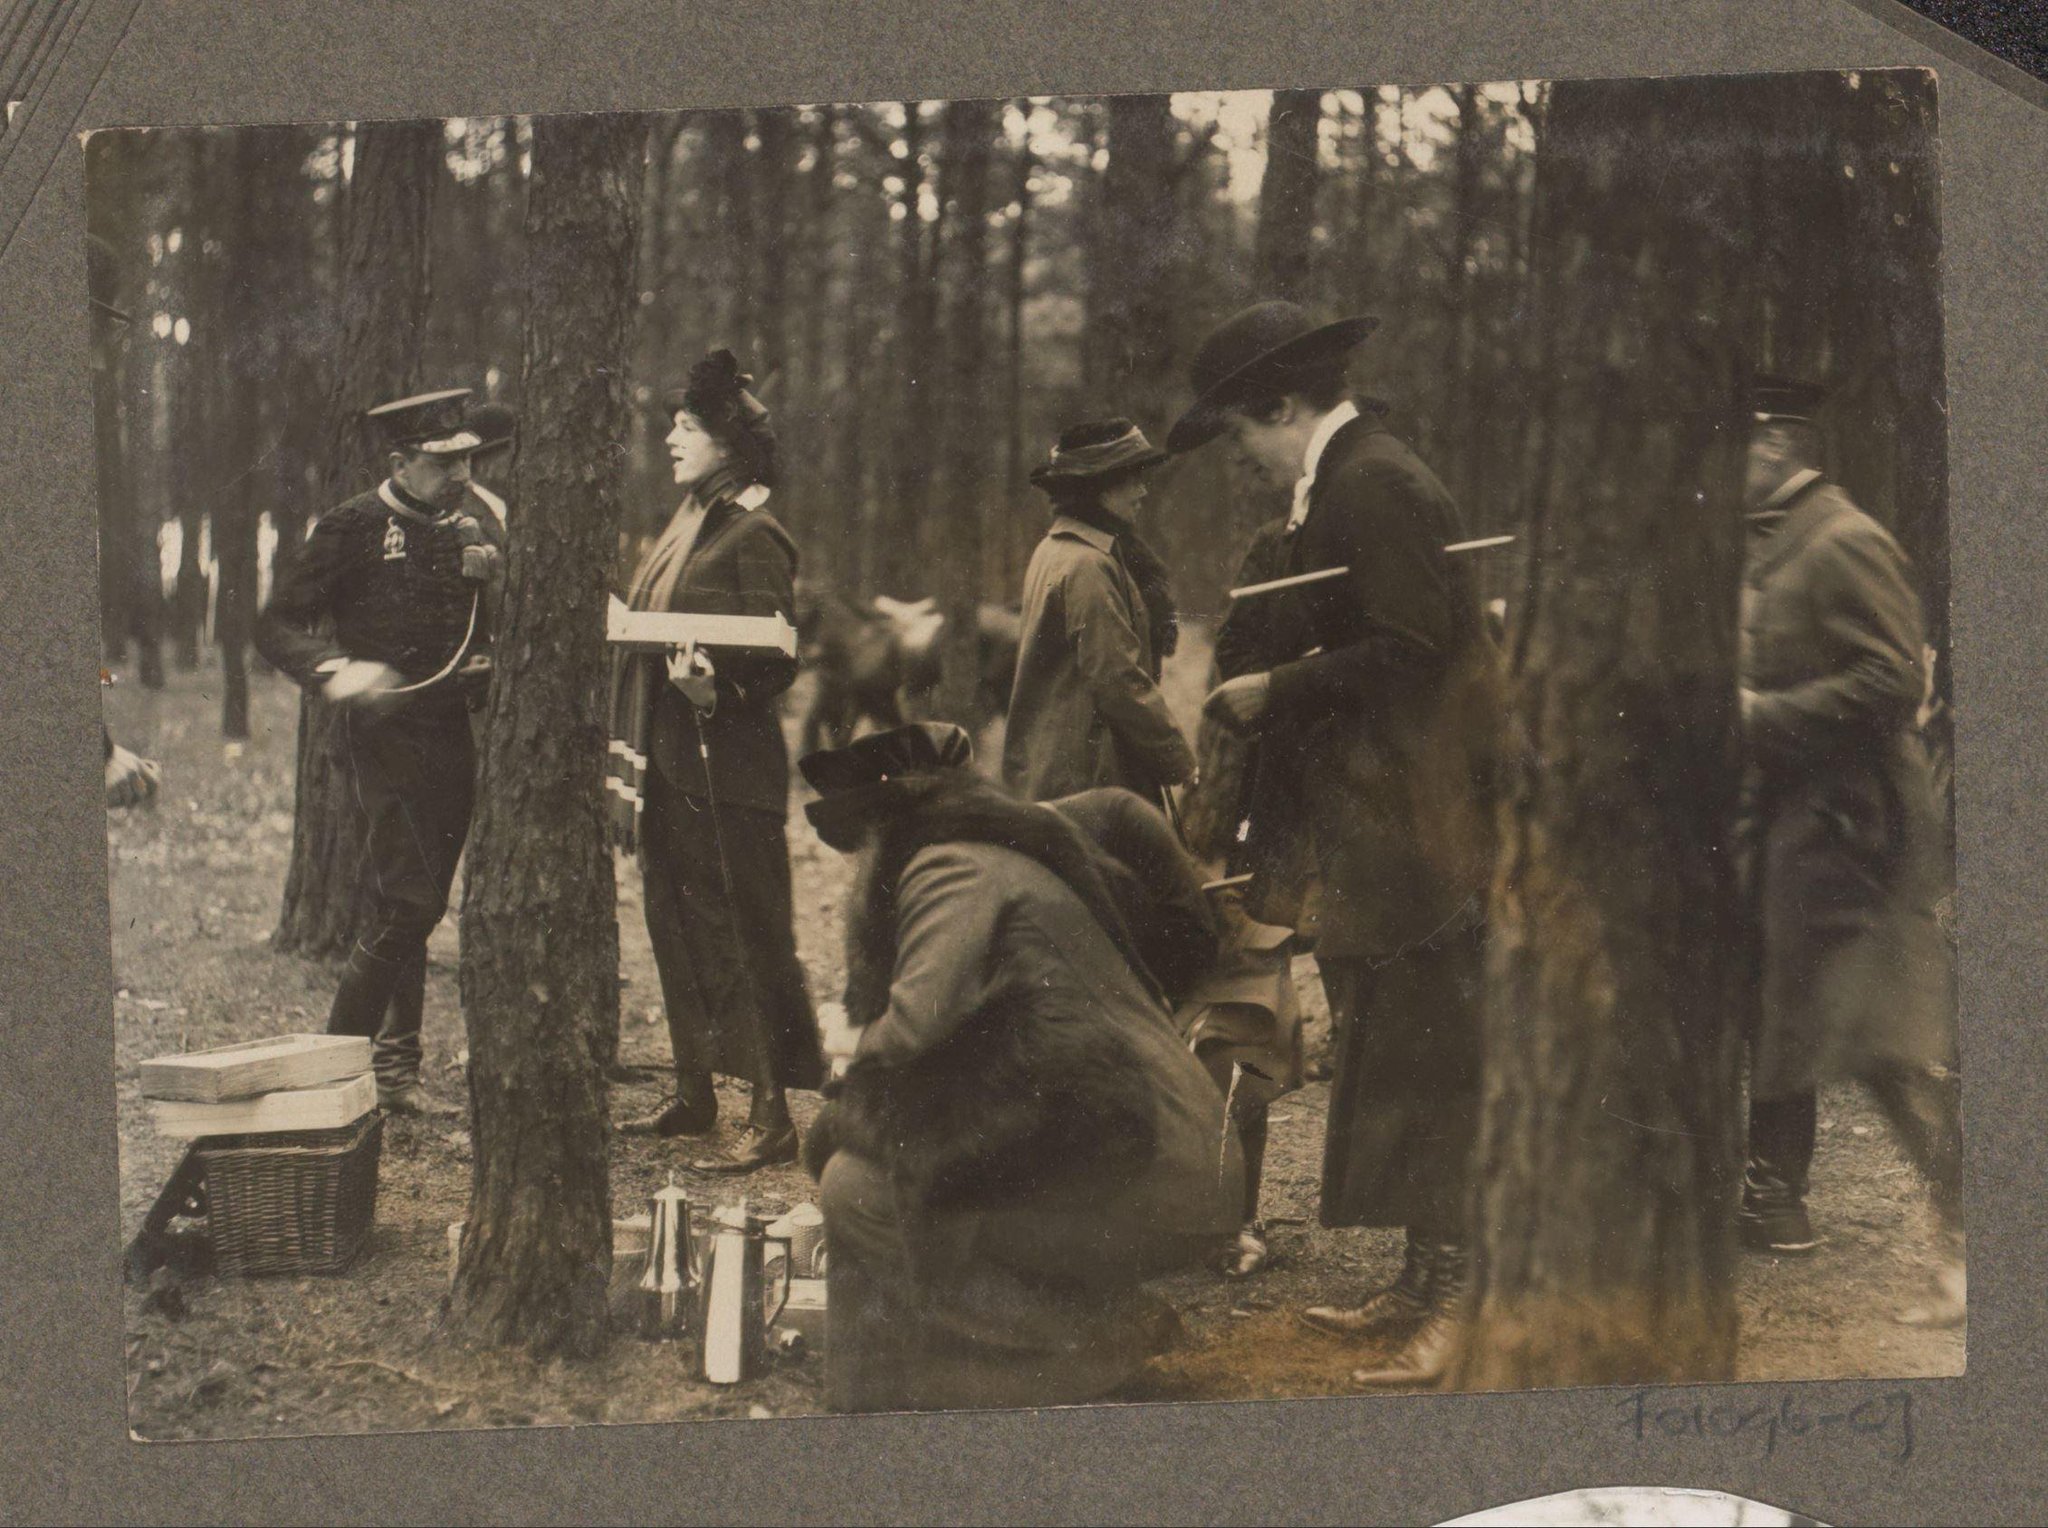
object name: album leaf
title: Ruitertafereel op Koninklijke Houtvesterij Het Loo: ruiters eten en drinken in een bos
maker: Anonymous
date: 1900-1925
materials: photographic support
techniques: gelatin silver print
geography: het loo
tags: hunting, chase, hunting-ground, eating and drinking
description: Onderdeel van Fotoalbum van de heer Brams, opperhoutvester van koningin Wilhelmina op Koninklijke Houtvesterij Het Loo.